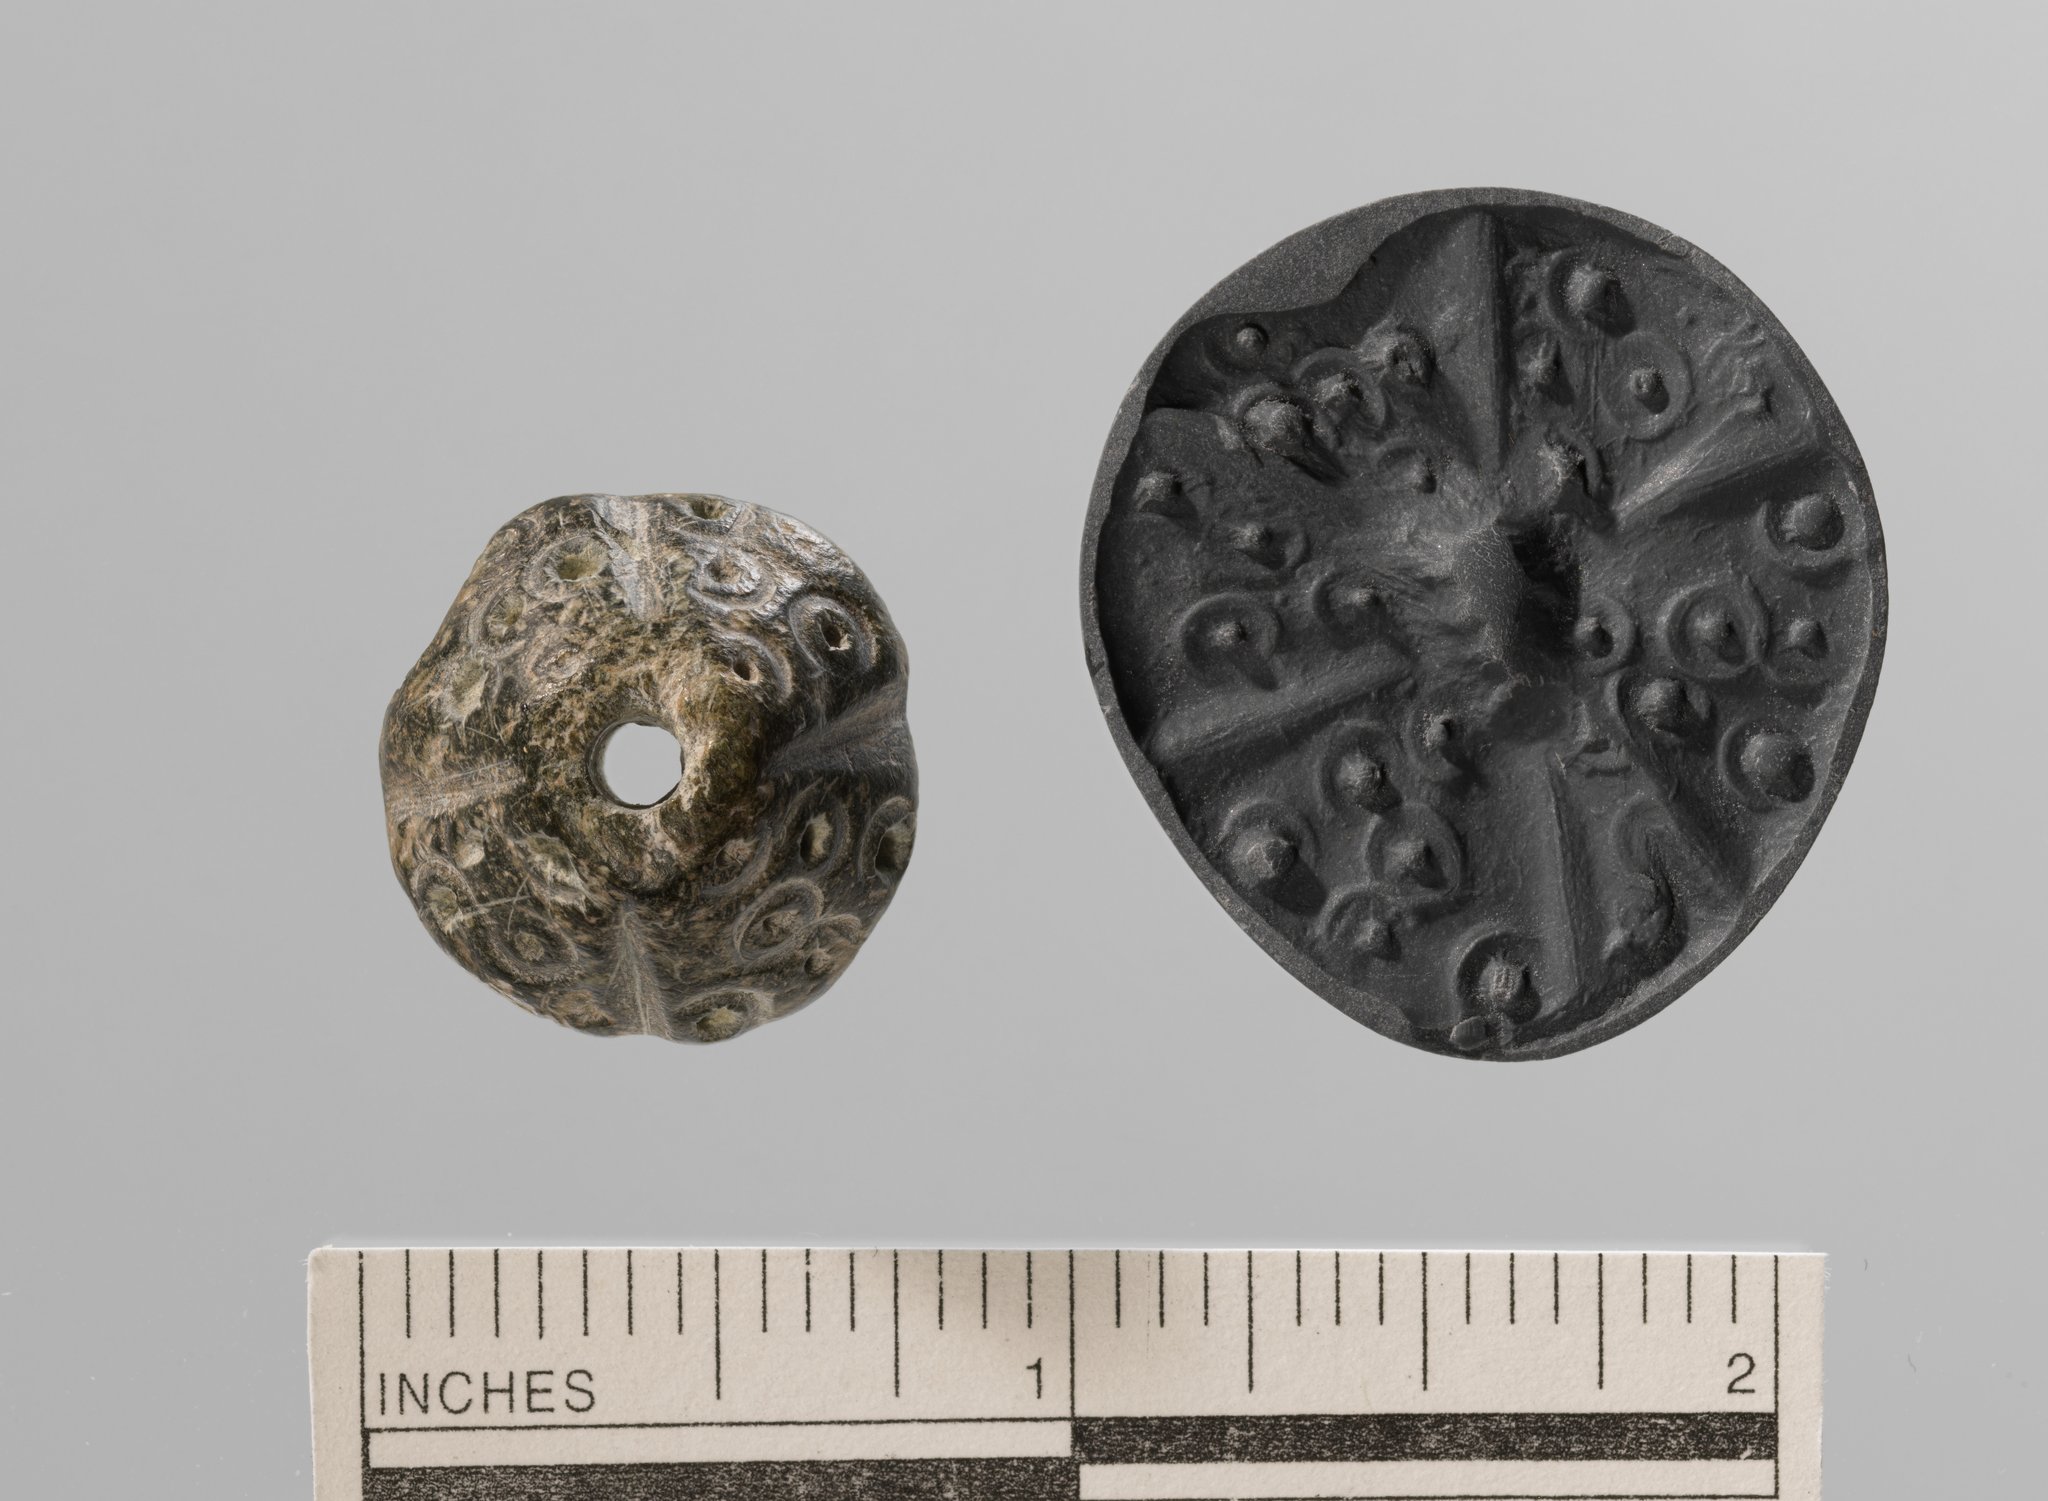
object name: spindle whorl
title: Steatite Spindle Whorl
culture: minoan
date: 1800-1700 BCE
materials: stone